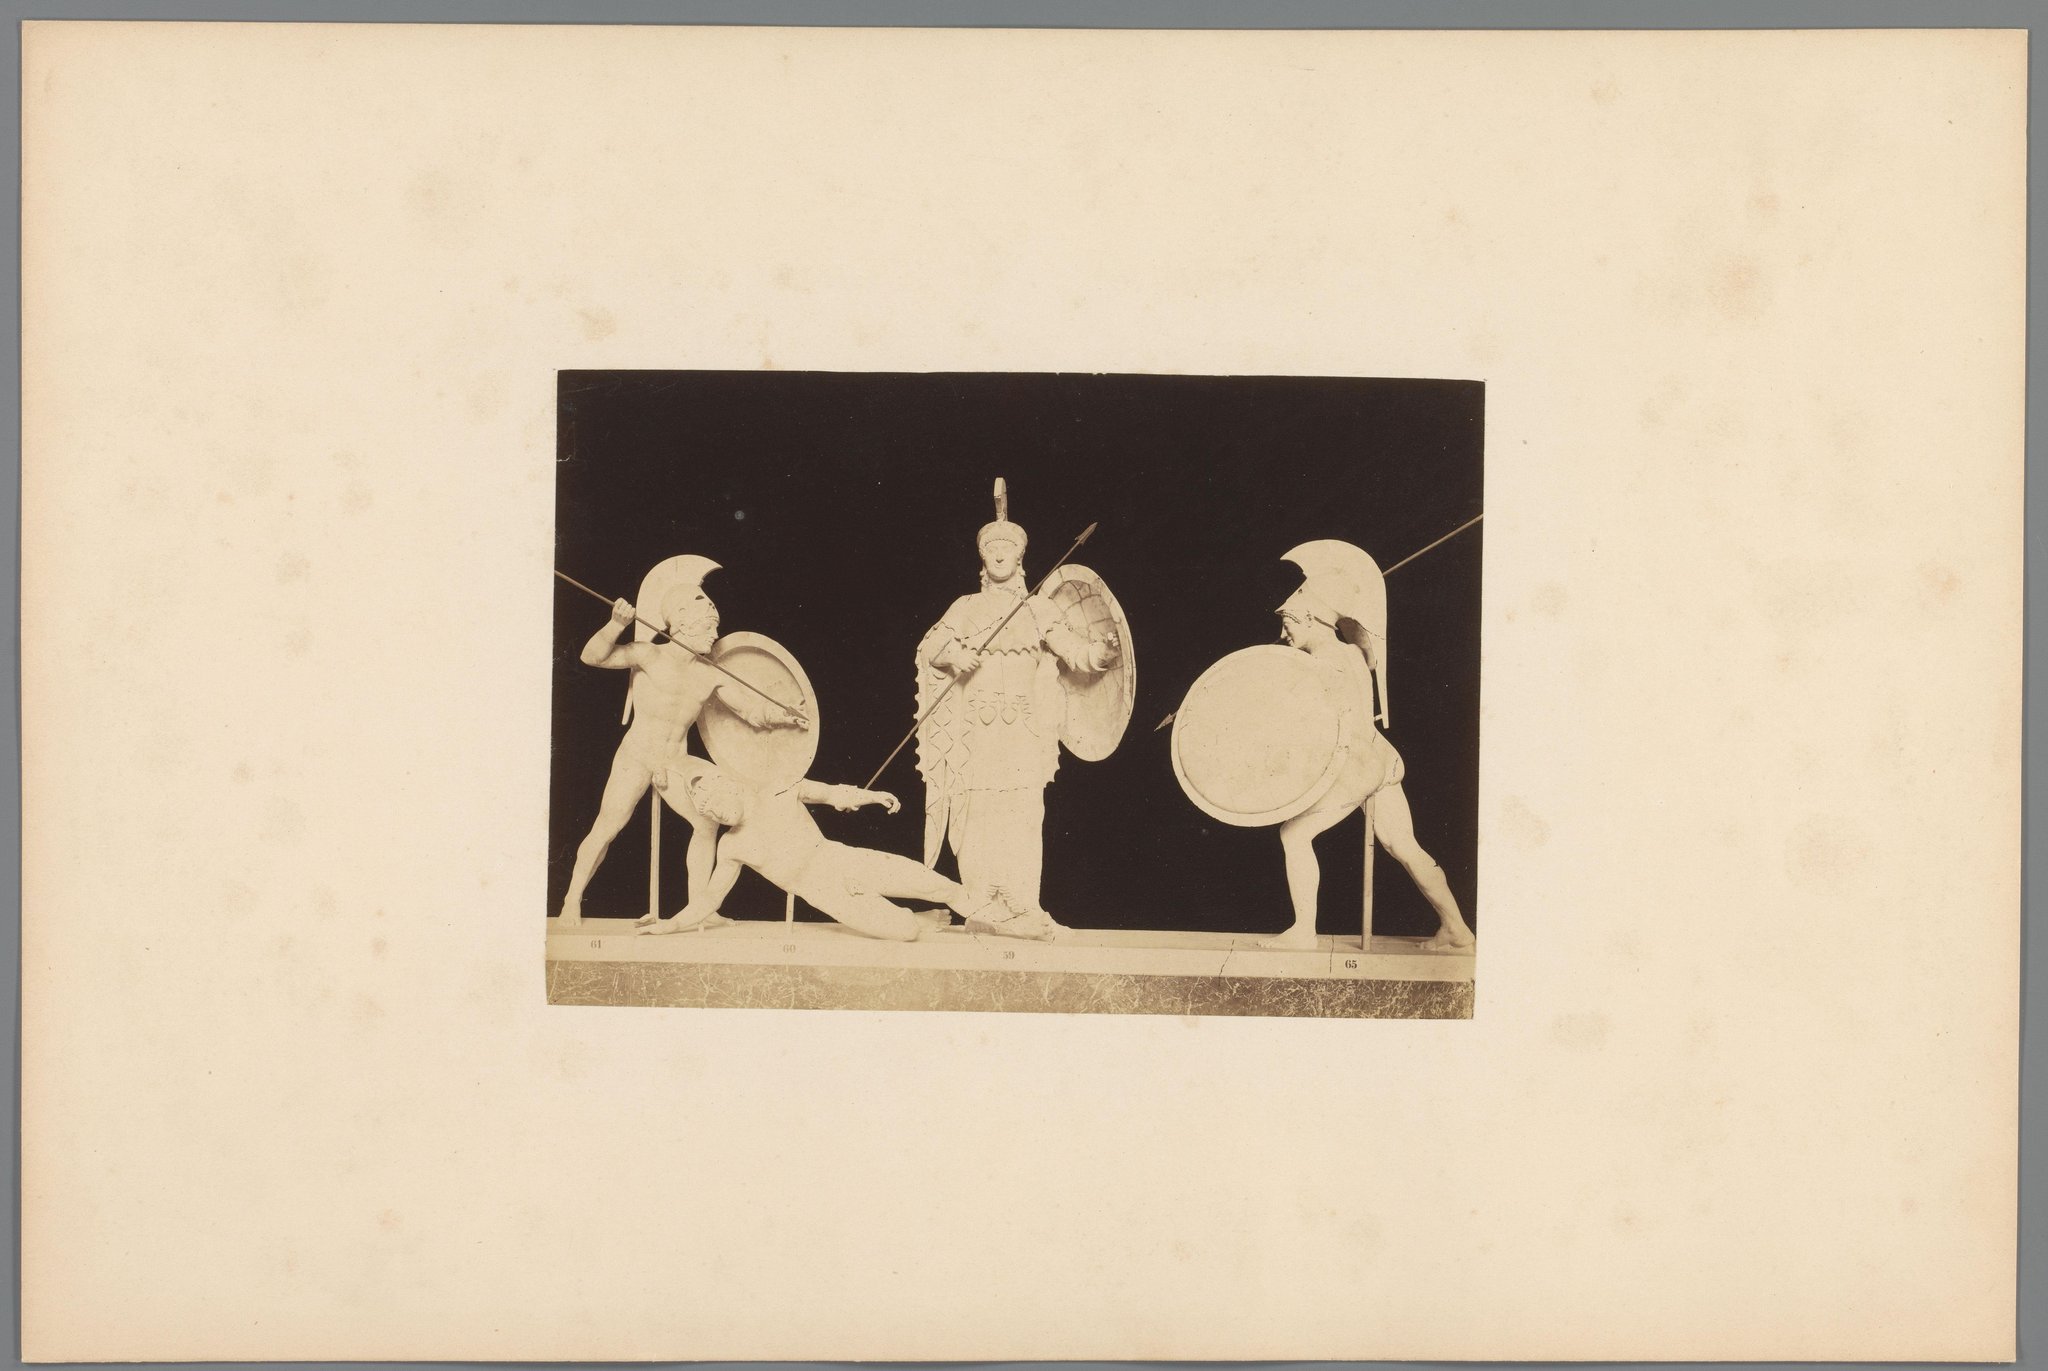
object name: photograph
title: Beeldengroep de Aegineten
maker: Anonymous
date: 1851-1900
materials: cardboard, paper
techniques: albumen print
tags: piece of sculpture, reproduction of a piece of sculpture